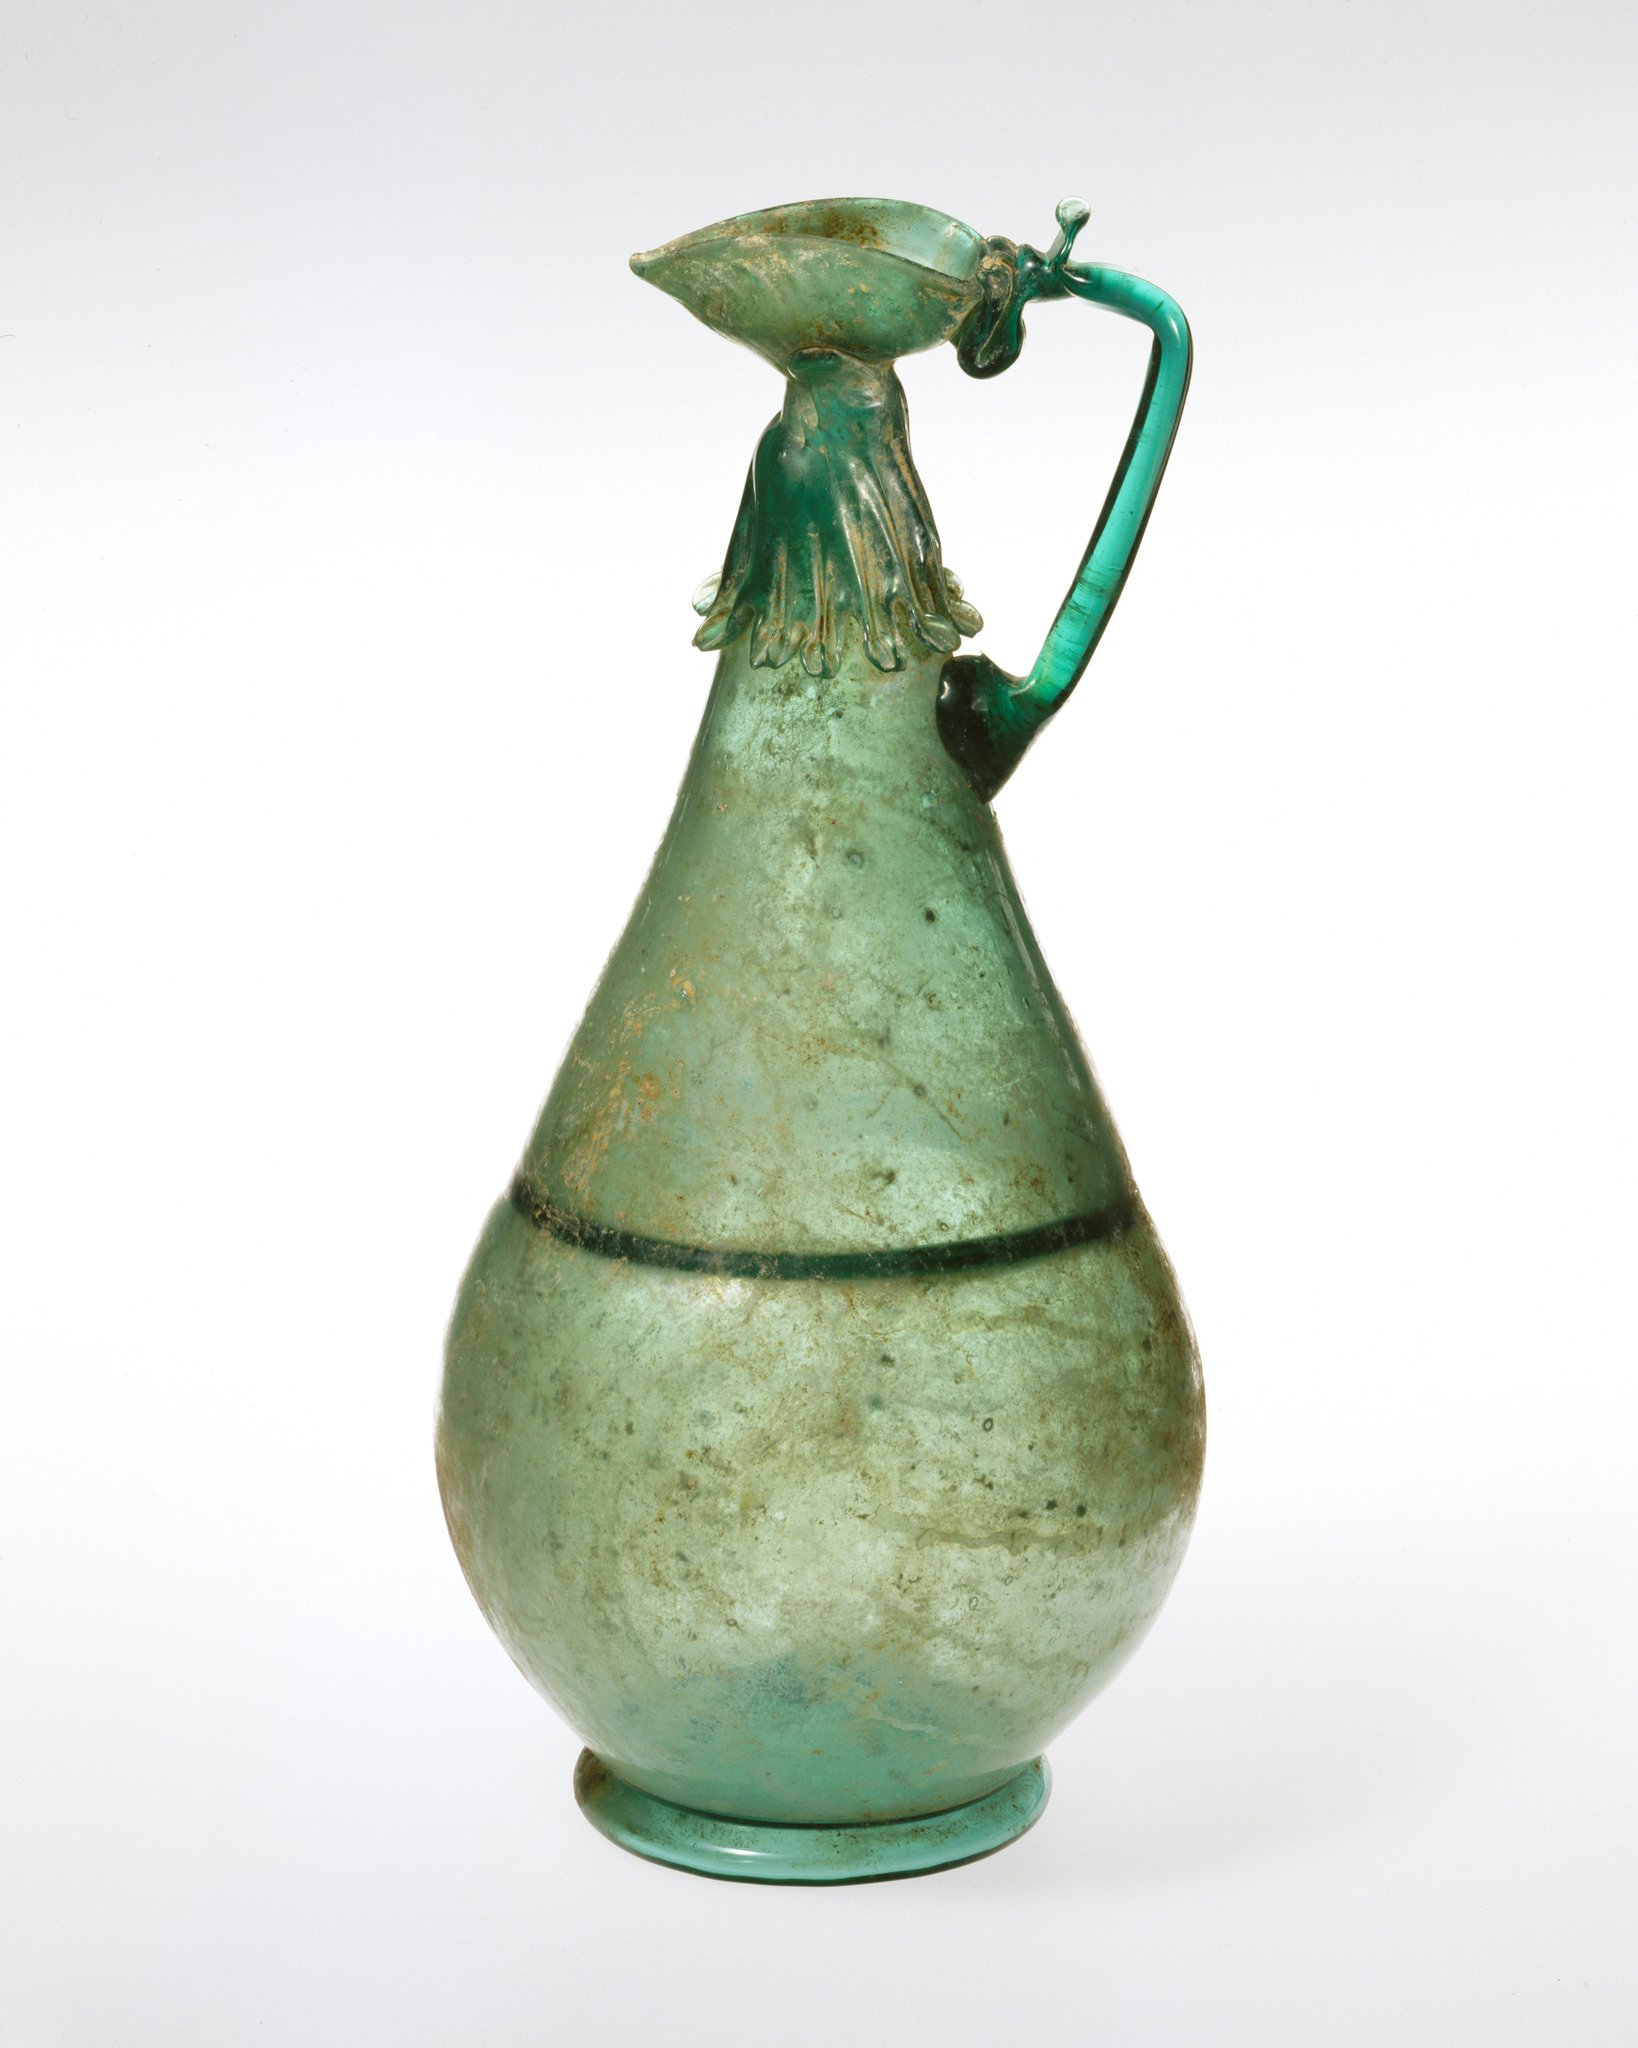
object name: ewer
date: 1101-1200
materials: glass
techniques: glassblowing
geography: iran